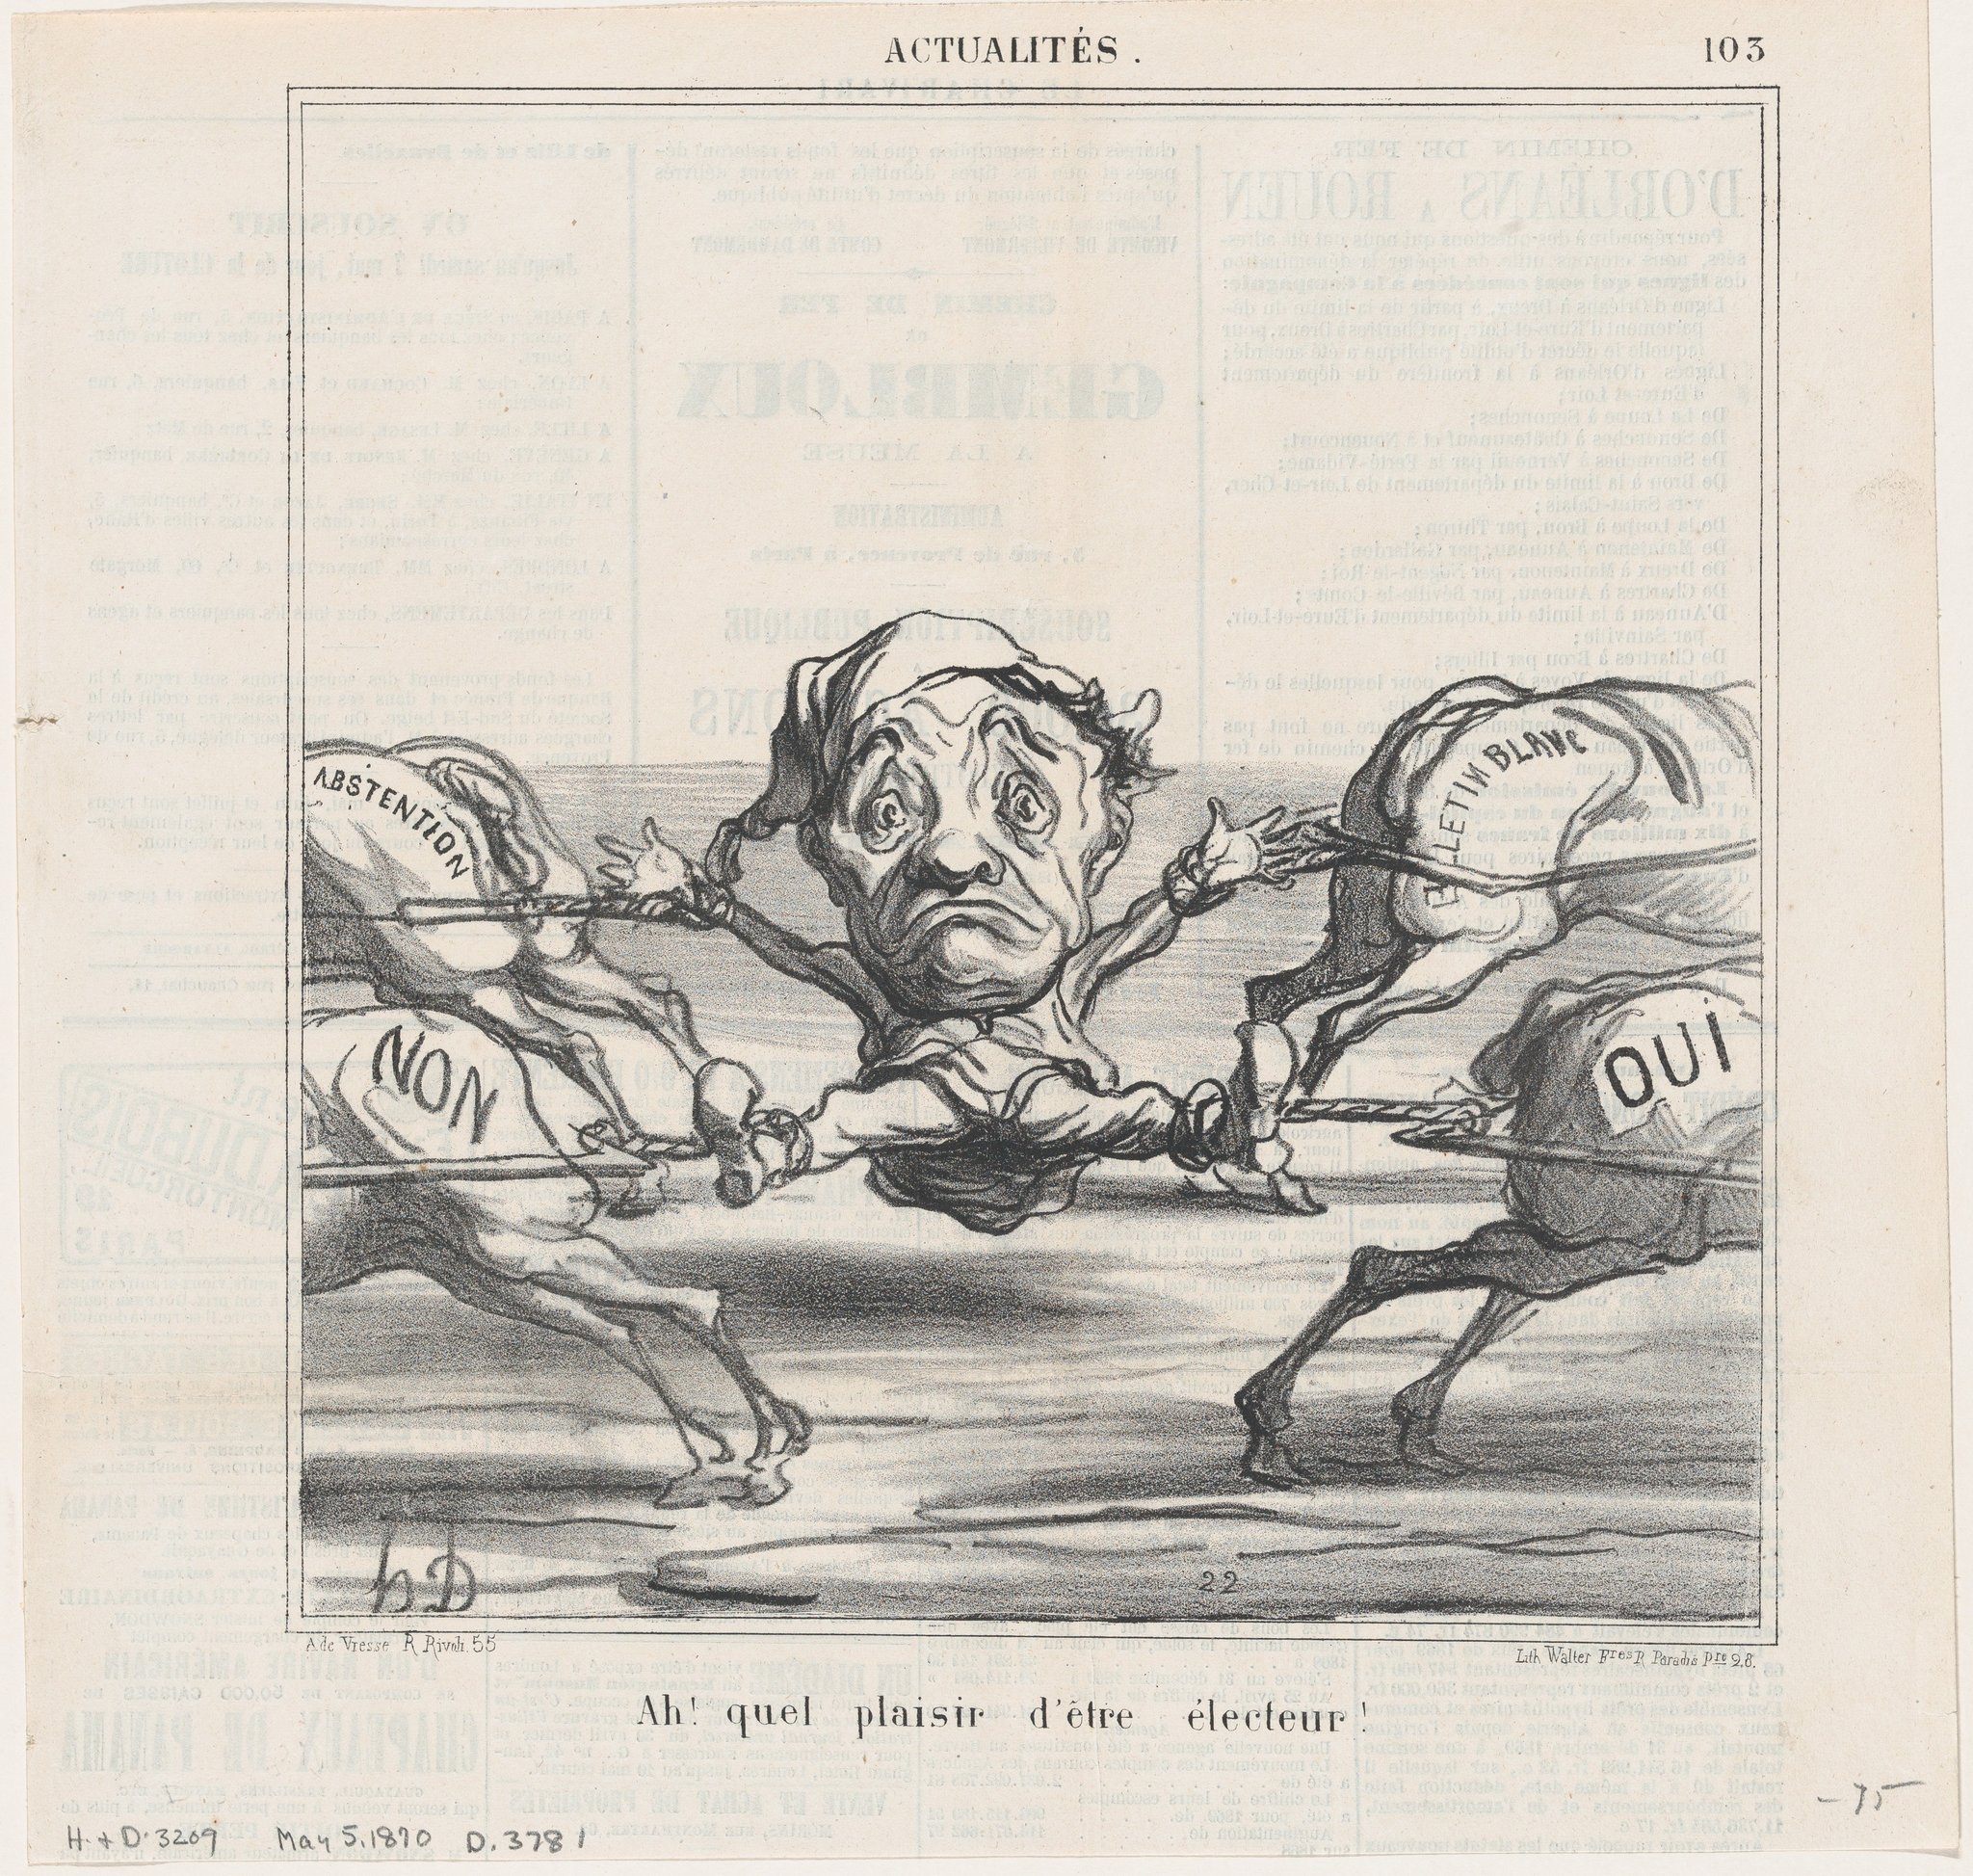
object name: print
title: What a joy to be a voter!, from 'News of the day,' published in Le Charivari, May 5, 1870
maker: honoré daumier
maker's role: artist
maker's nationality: french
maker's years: 1808-1879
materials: paper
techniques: lithograph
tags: satire,men